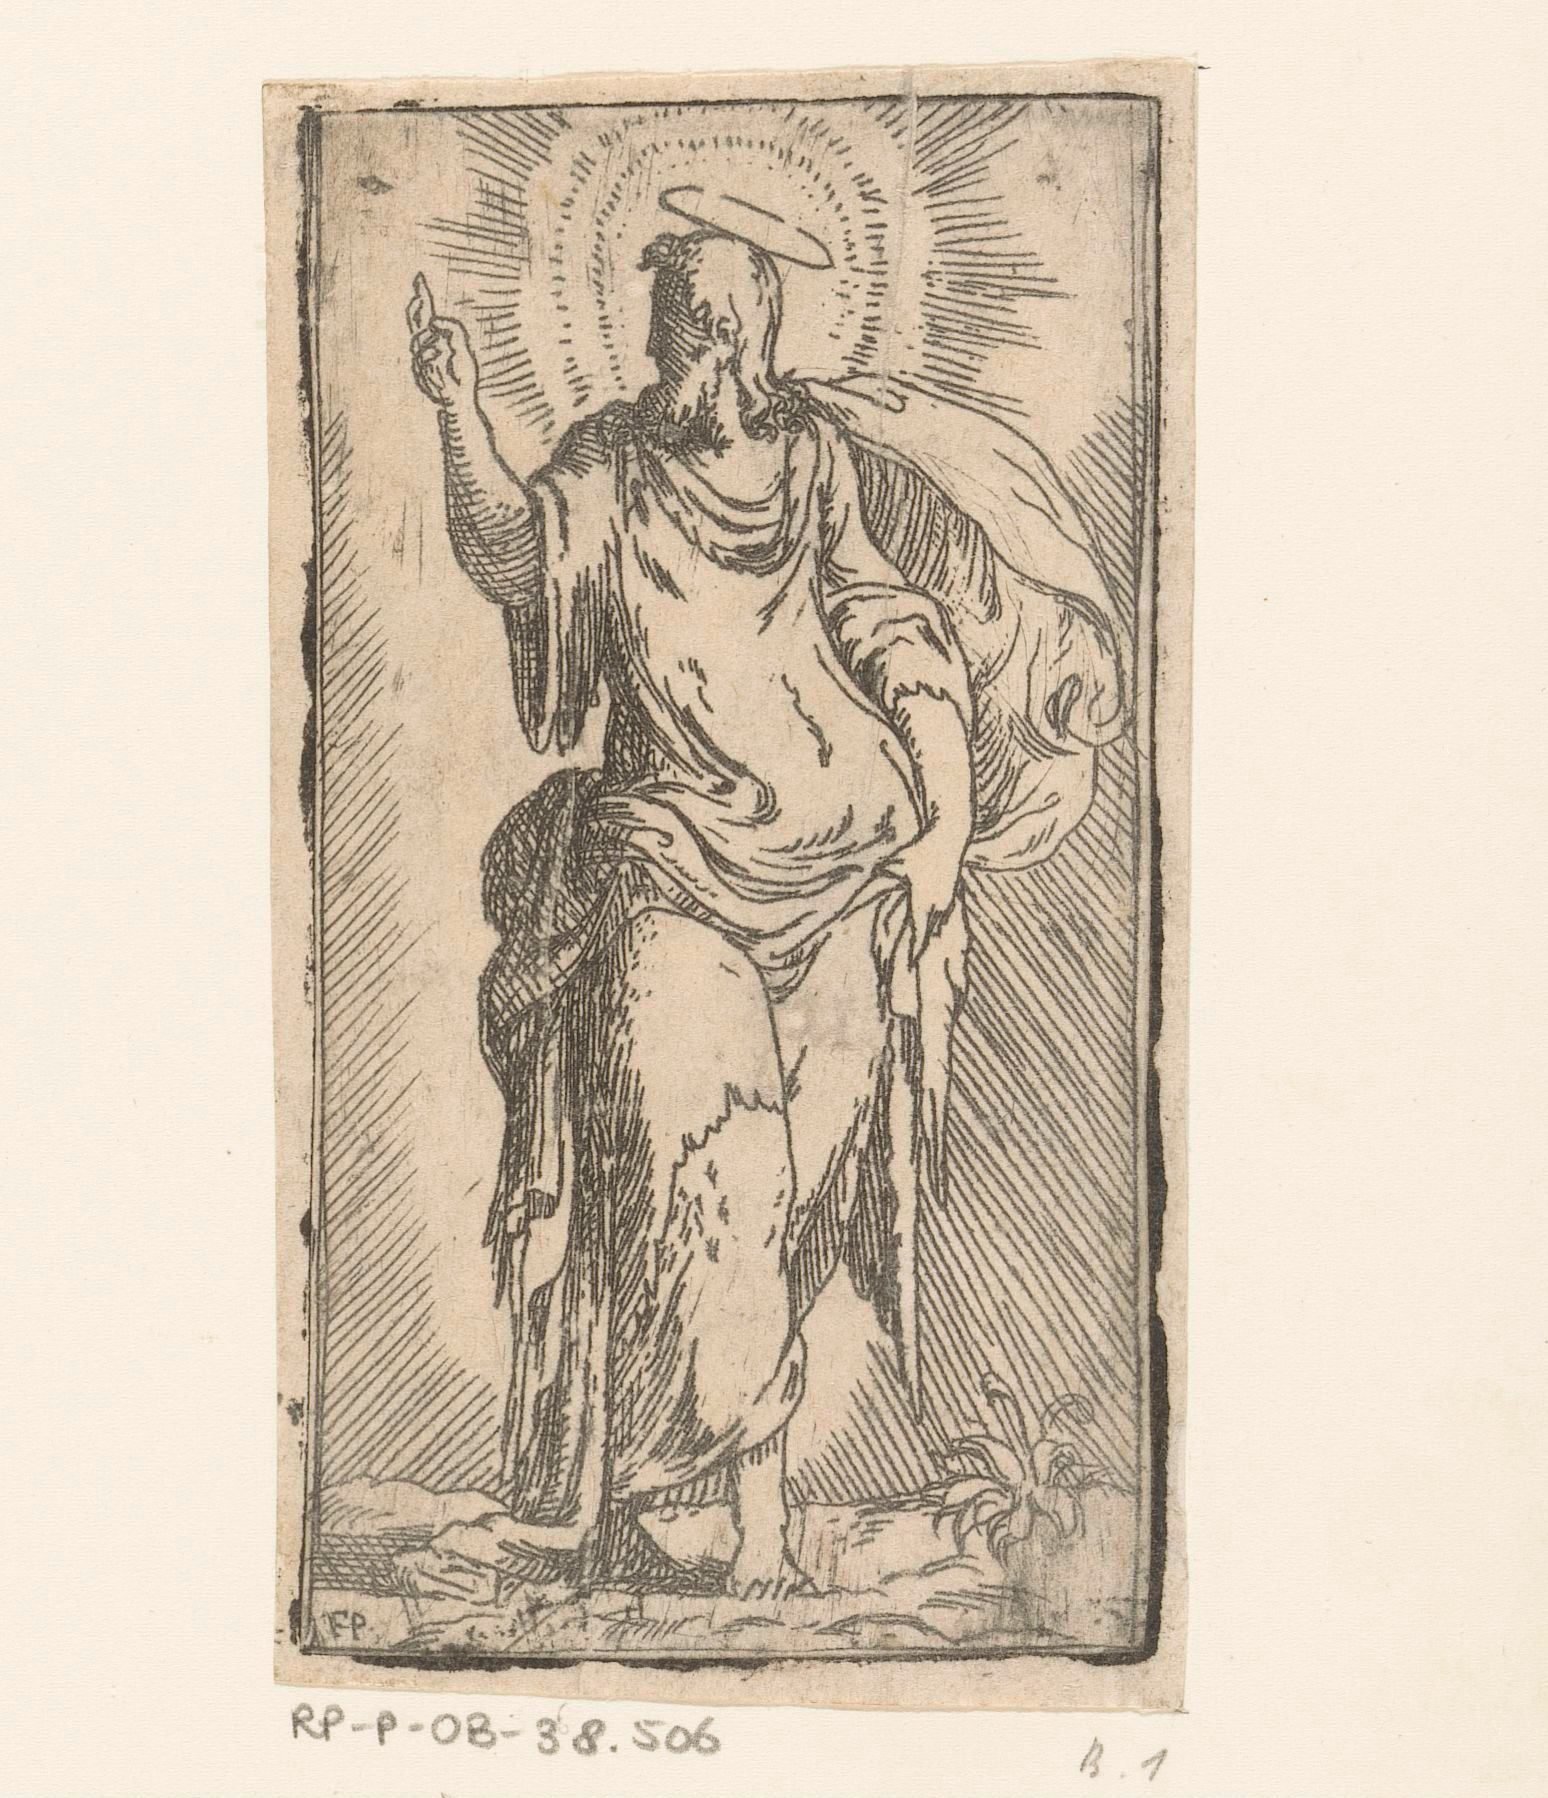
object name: print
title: Christus en de apostelen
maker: monogrammist fp (italië; 16e eeuw)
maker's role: print maker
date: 1500-1599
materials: paper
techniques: etching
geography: italy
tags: christ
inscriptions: collector's mark: Lugt 240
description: Deze prent maakt deel uit van een reeks van dertien prenten van Christus en de twaalf apostelen.